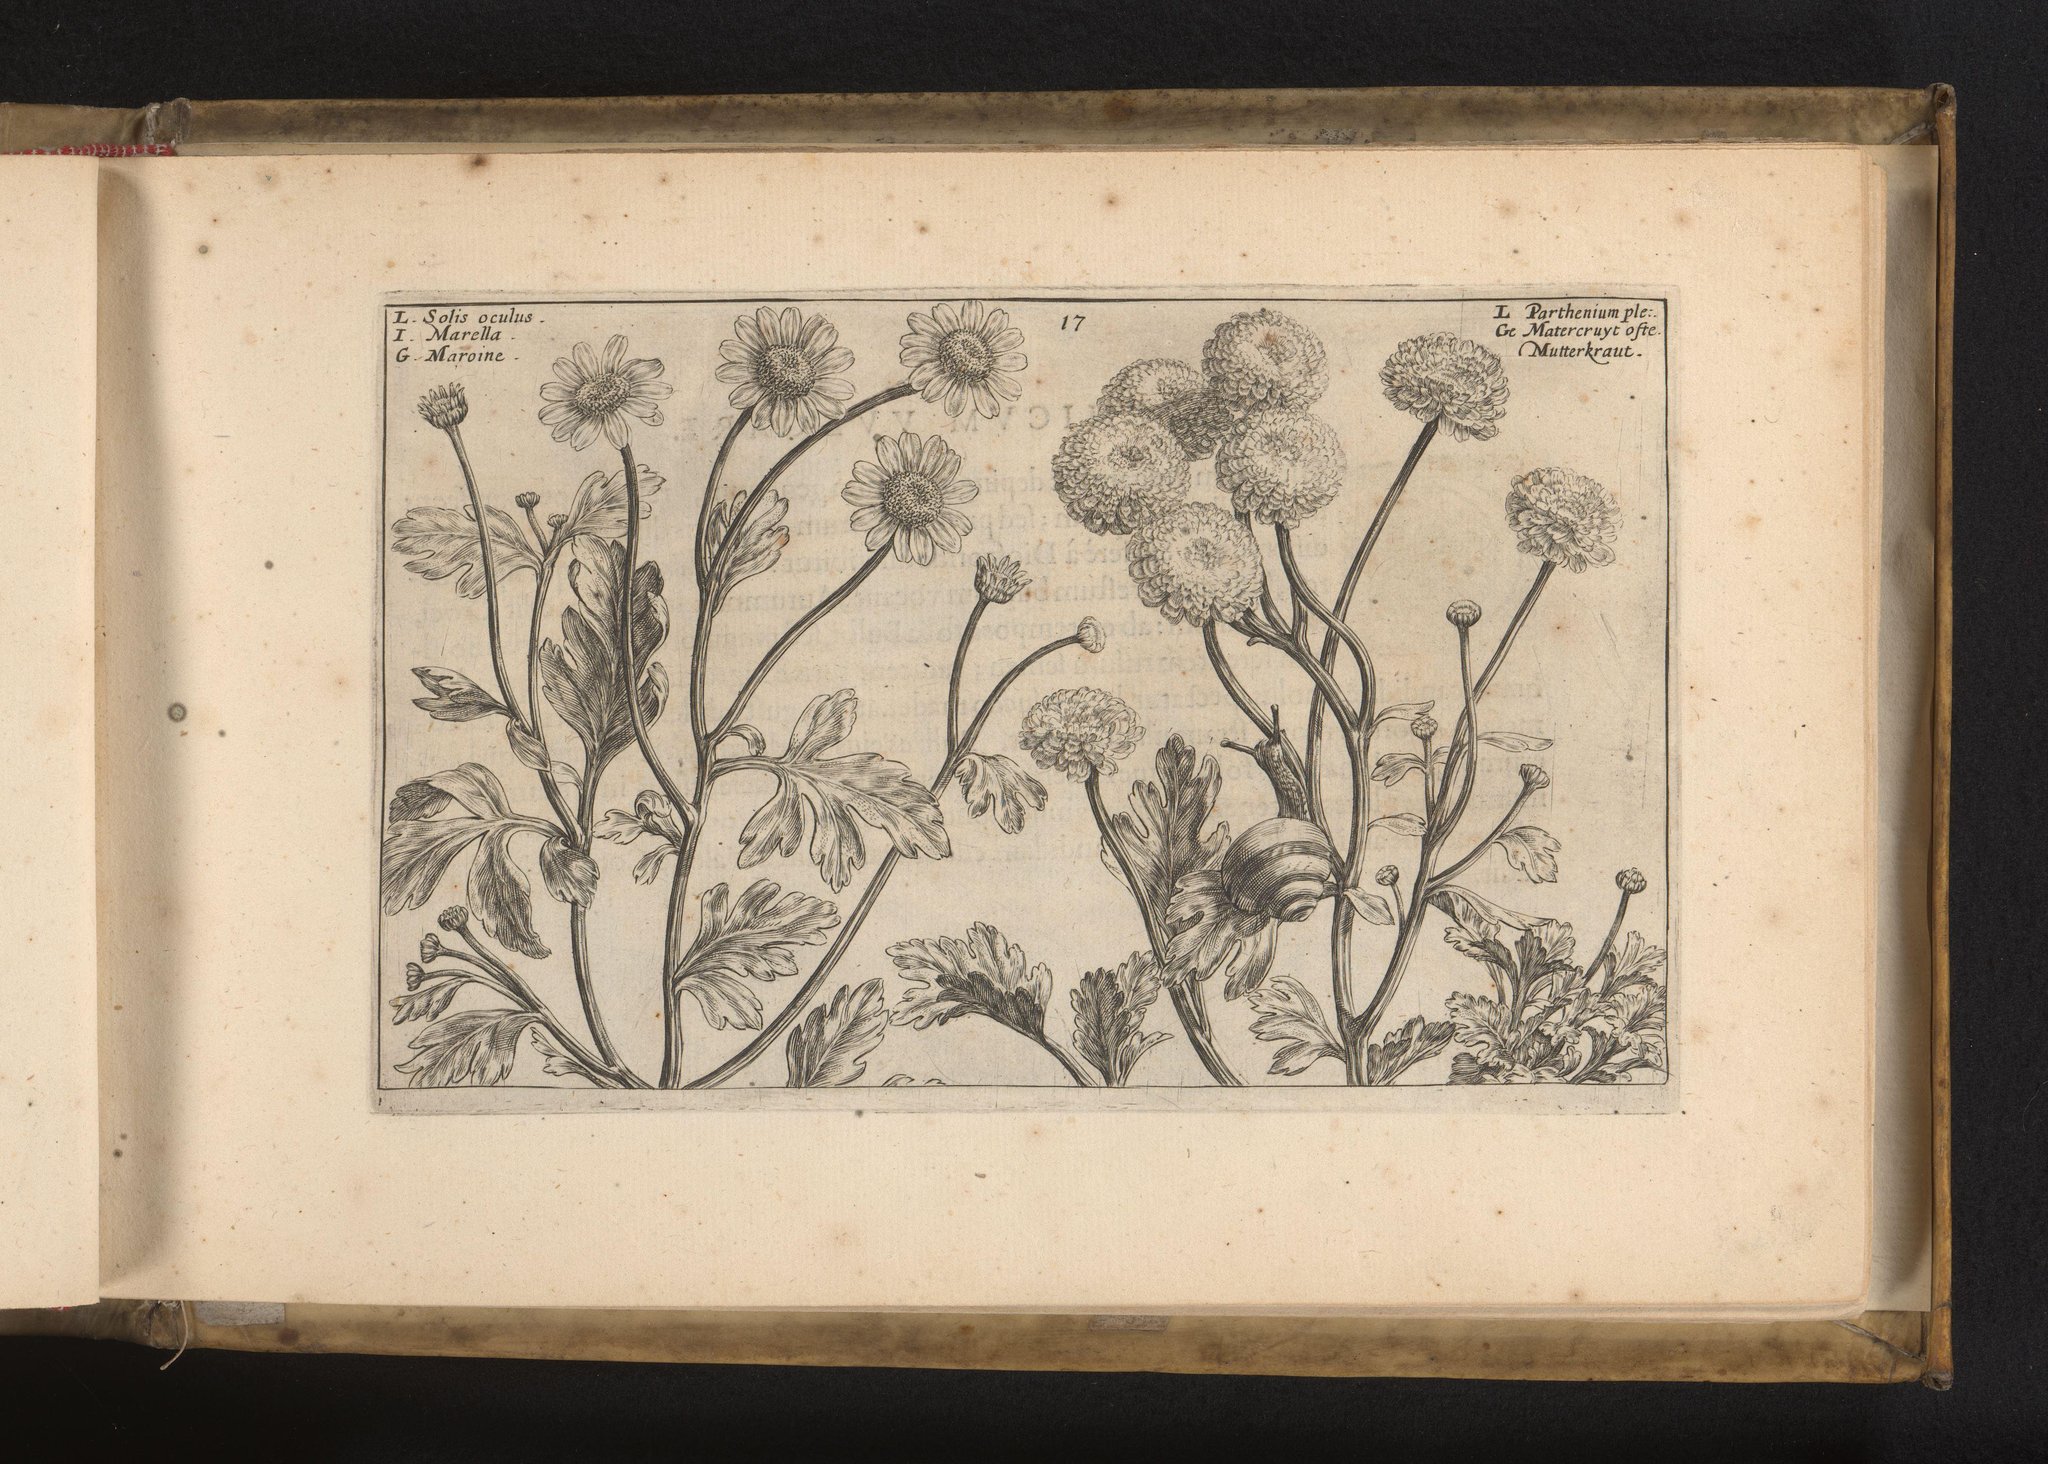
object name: book illustration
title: Parthenium ple. / Matercruyt ofte Mutterkraut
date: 1617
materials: paper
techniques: engraving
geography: utrecht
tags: flowers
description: Prent uit: Passe, Crispijn van de (II). Hortus floridus in quo rariorum & minus vulgarium florum icones ad vivam veramque formam. Arnhem: Johannes Janssonius, 1617.